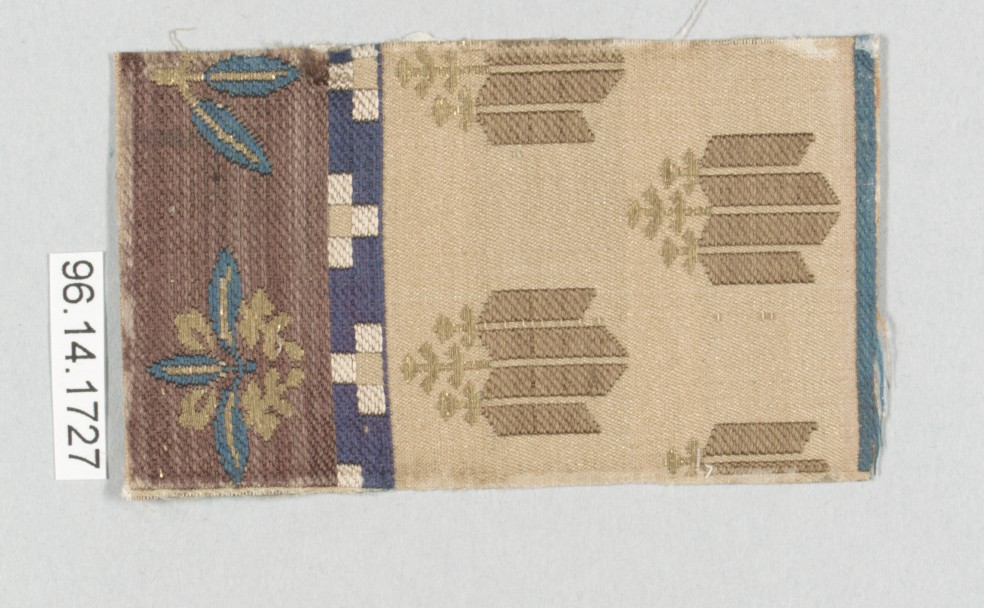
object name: piece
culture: japanese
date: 1801-1833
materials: metal thread, silk